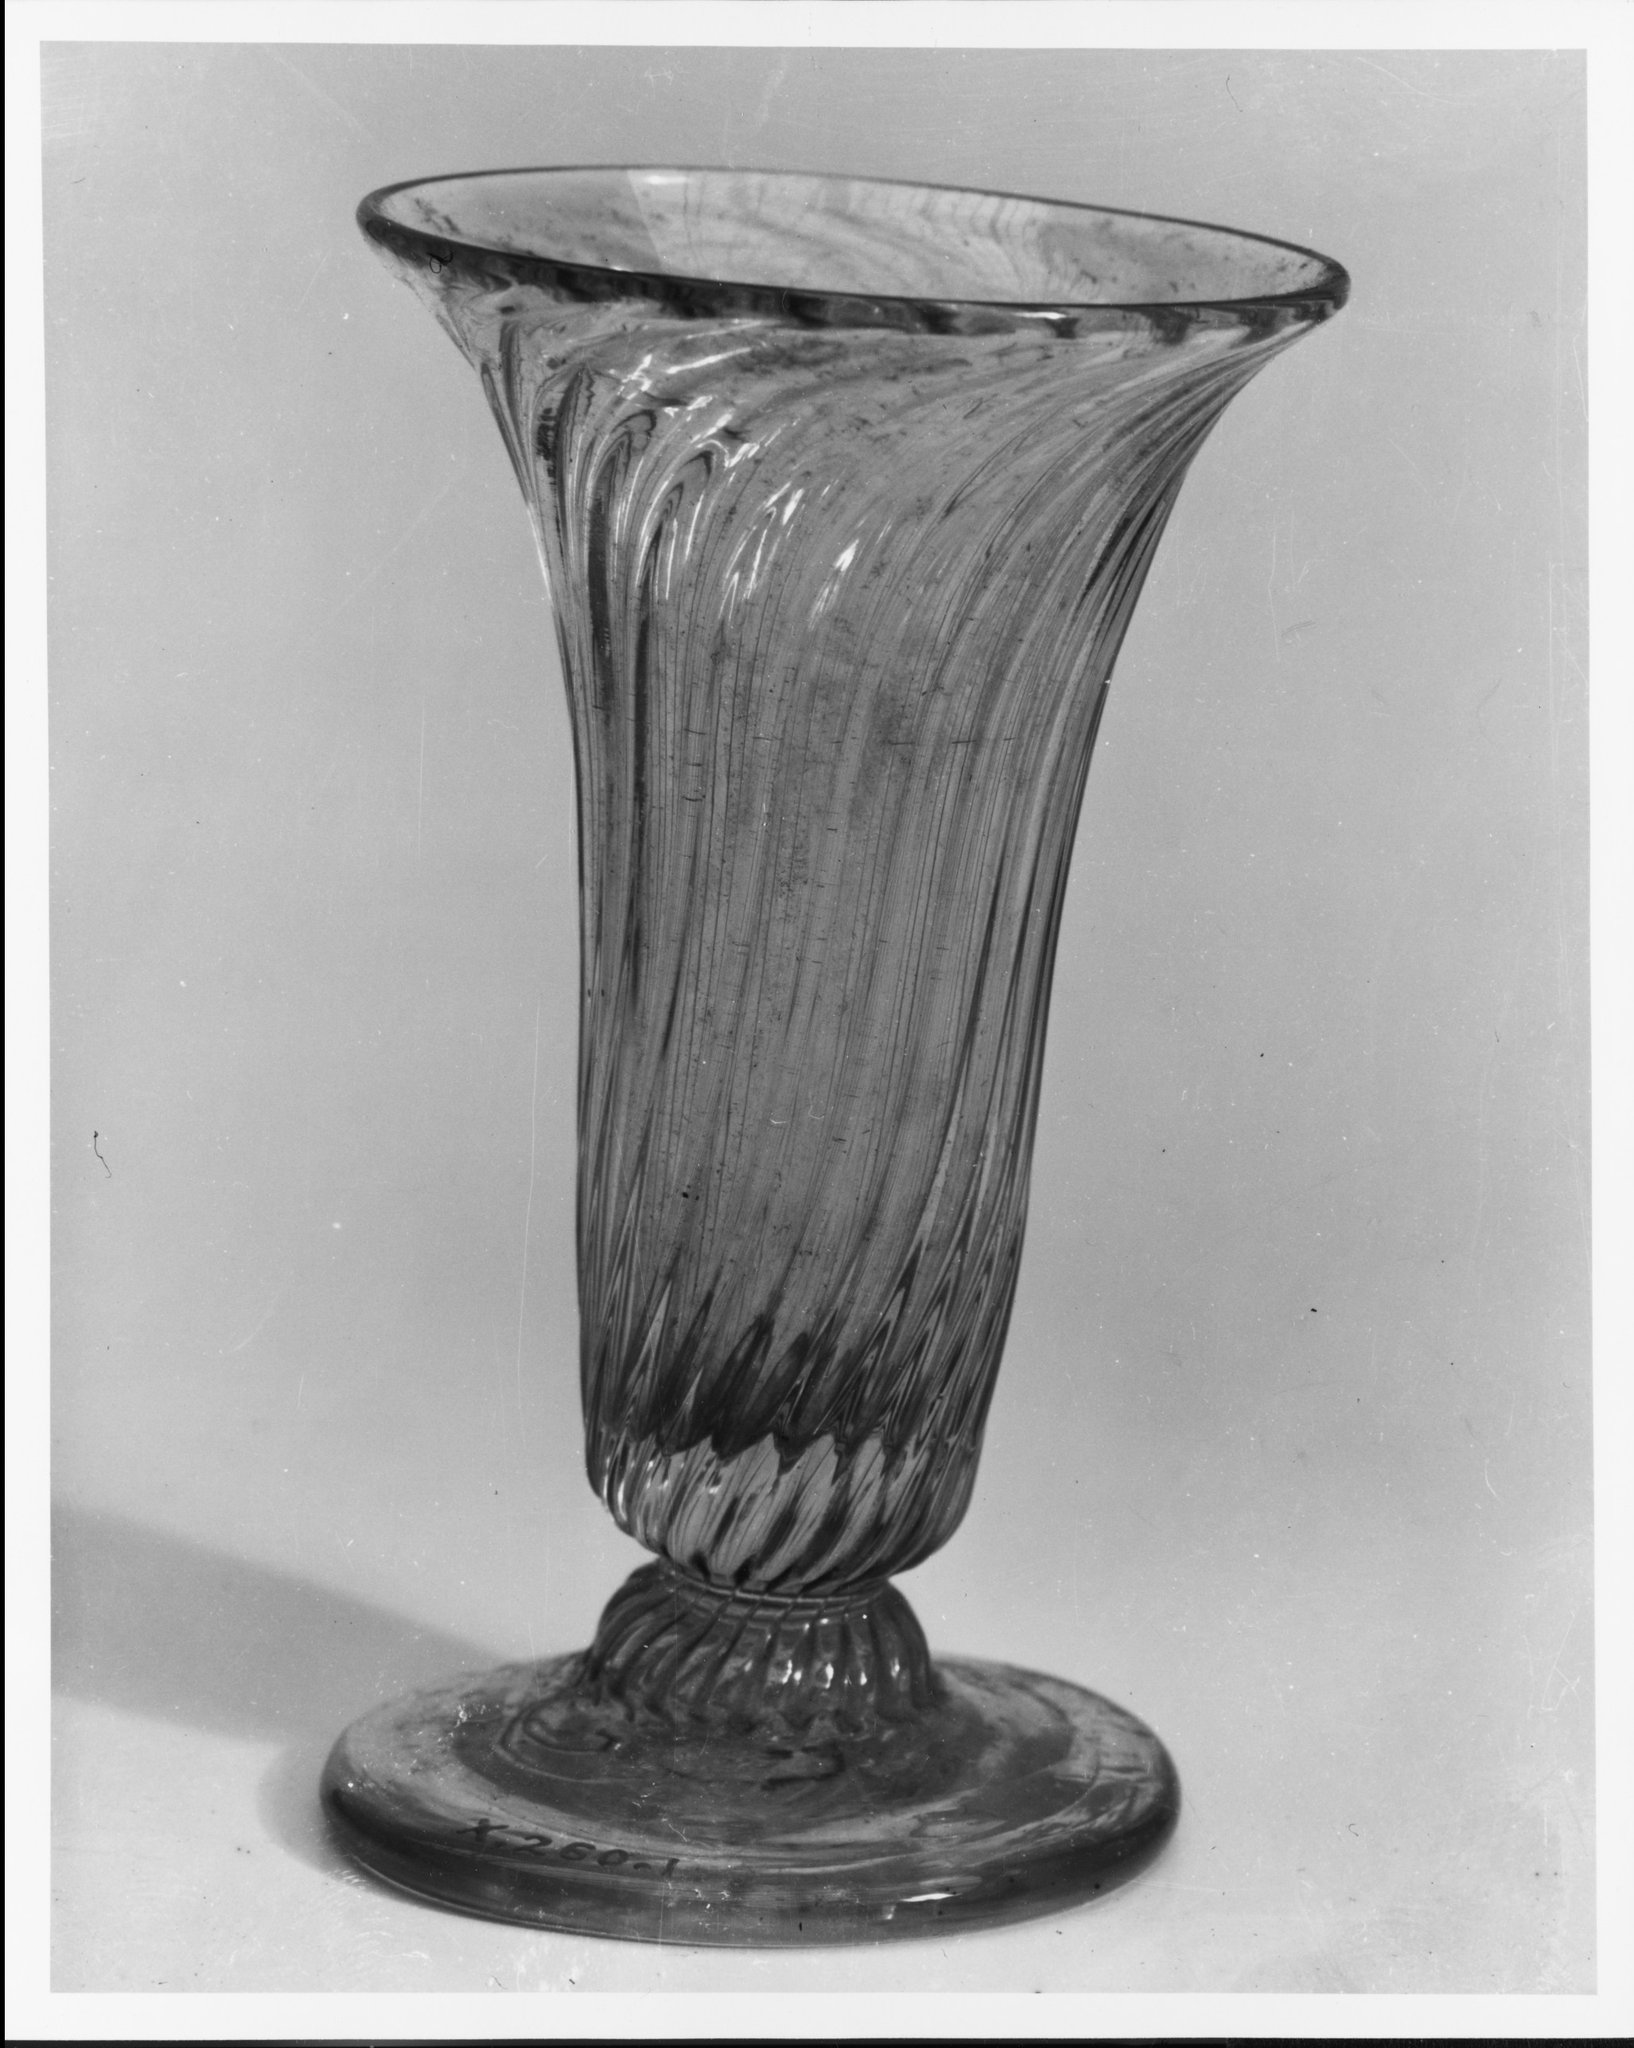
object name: jelly glass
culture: american or british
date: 1785-1825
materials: glass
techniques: glassblowing, molding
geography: england